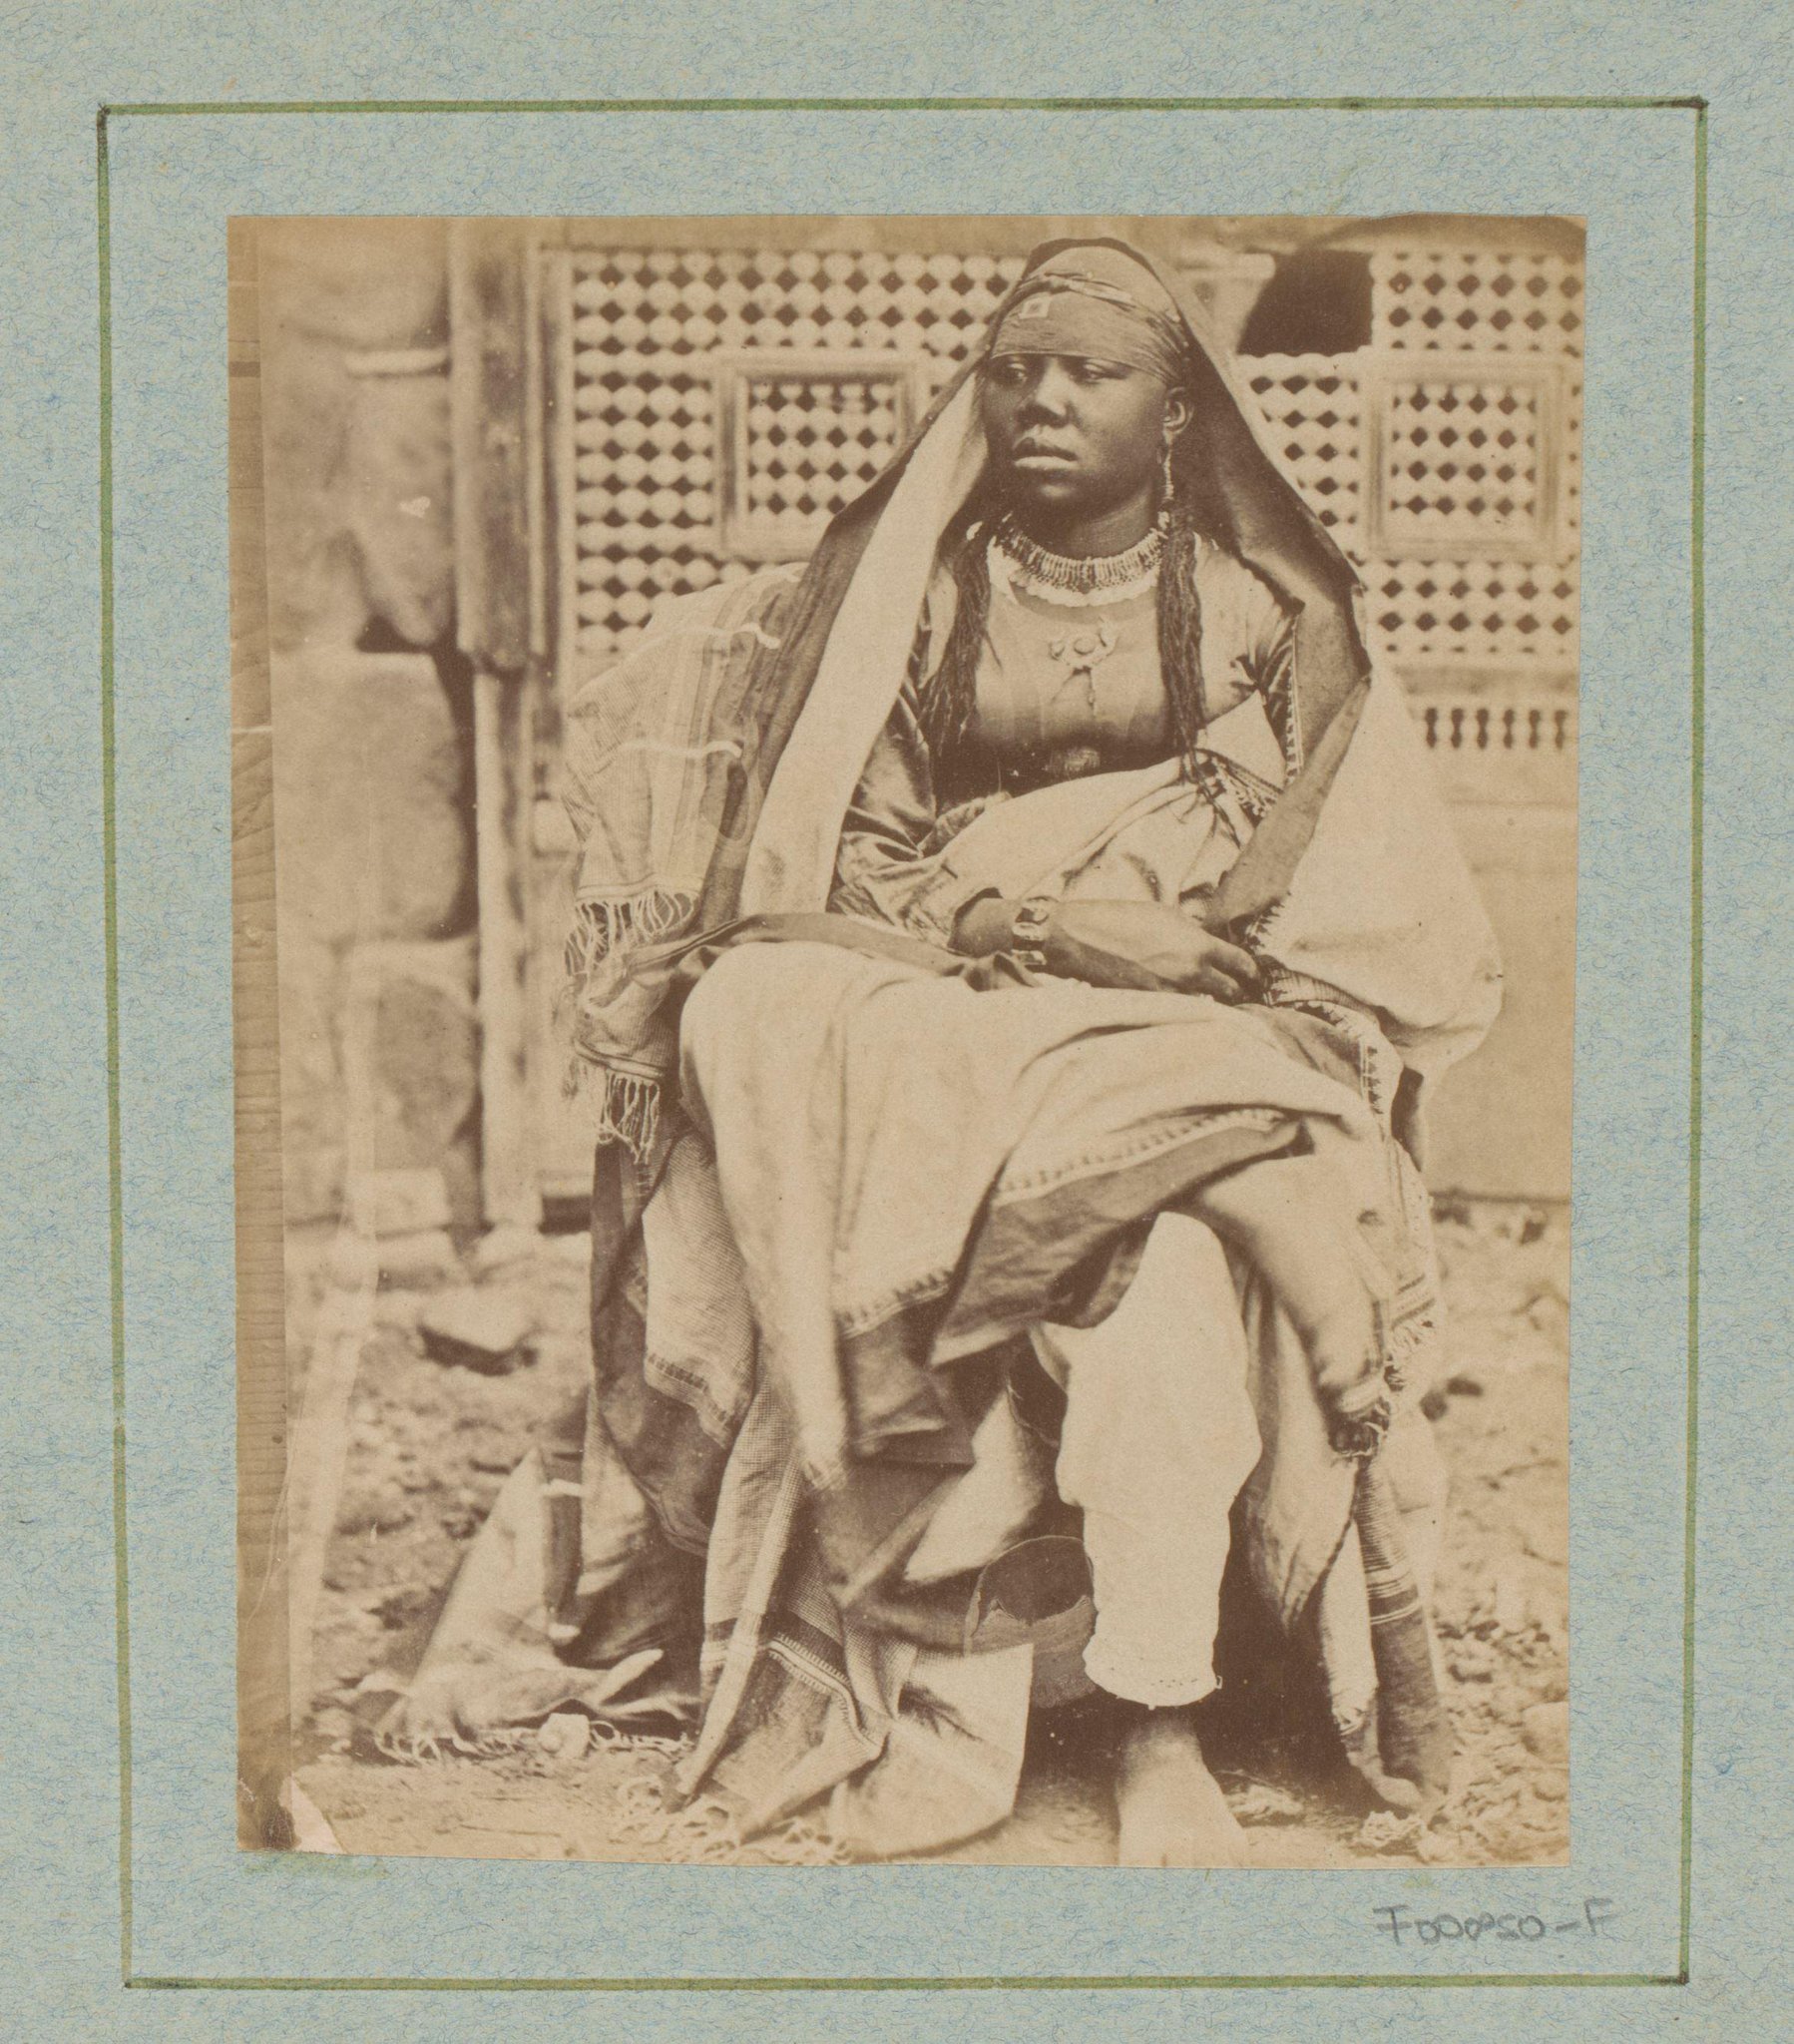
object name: photograph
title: Zittende Egyptische vrouw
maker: Anonymous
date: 1850-1890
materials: cardboard, photographic support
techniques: albumen print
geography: egypt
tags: adult woman, africans